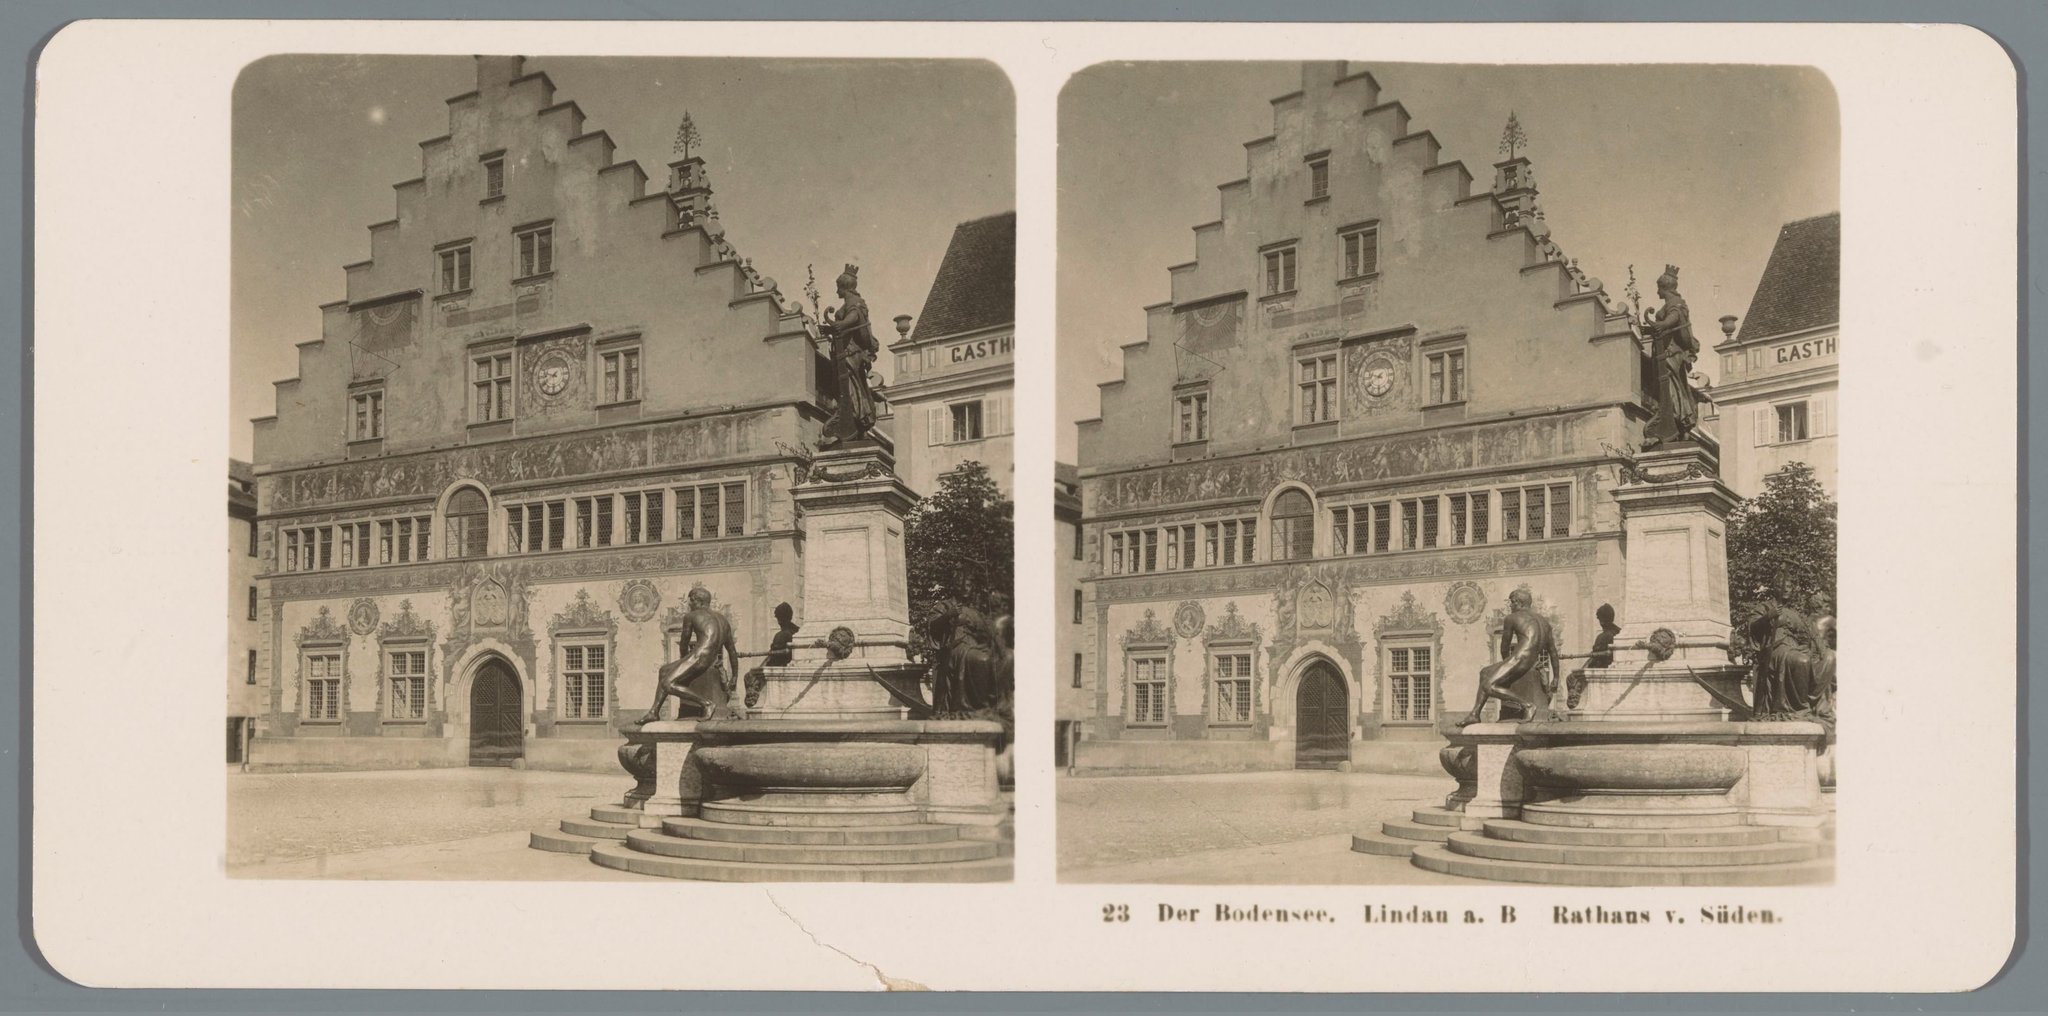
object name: stereograph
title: Gevel van het stadhuis van Lindau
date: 1906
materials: cardboard, photographic support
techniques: gelatin silver print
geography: lindau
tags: townhall, façade (of house or building)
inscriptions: inscription: ‘Neue Photographische Gesellschaft A.-G. Steglitz-Berlin. 1906.’, number: ‘23’